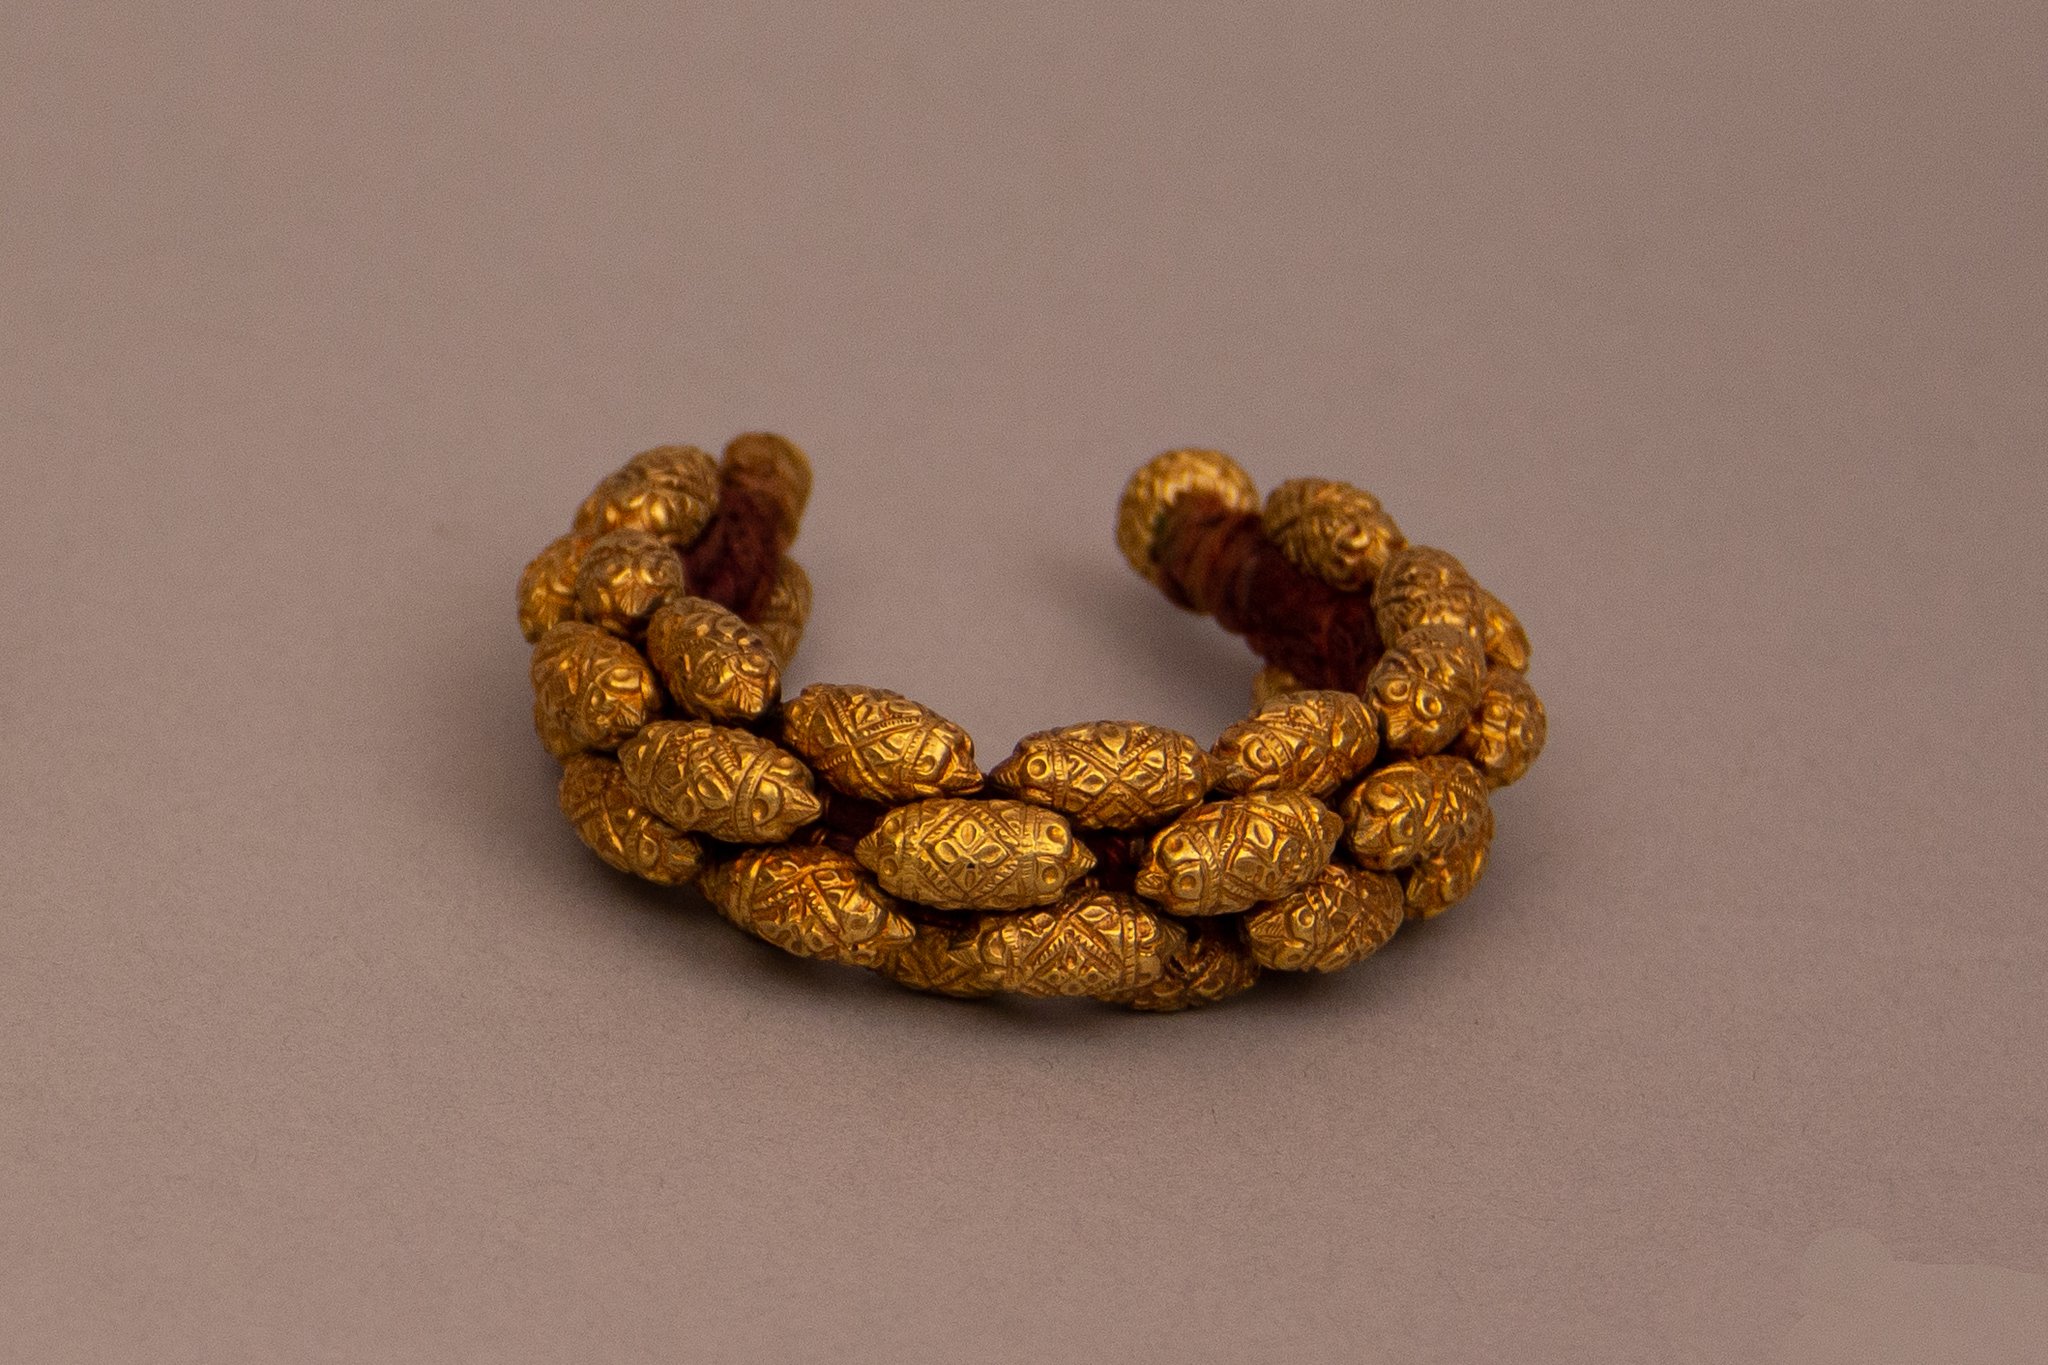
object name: bracelet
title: Bracelet (Pahunchi), One of a Pair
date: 1801-1900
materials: gold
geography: northern india